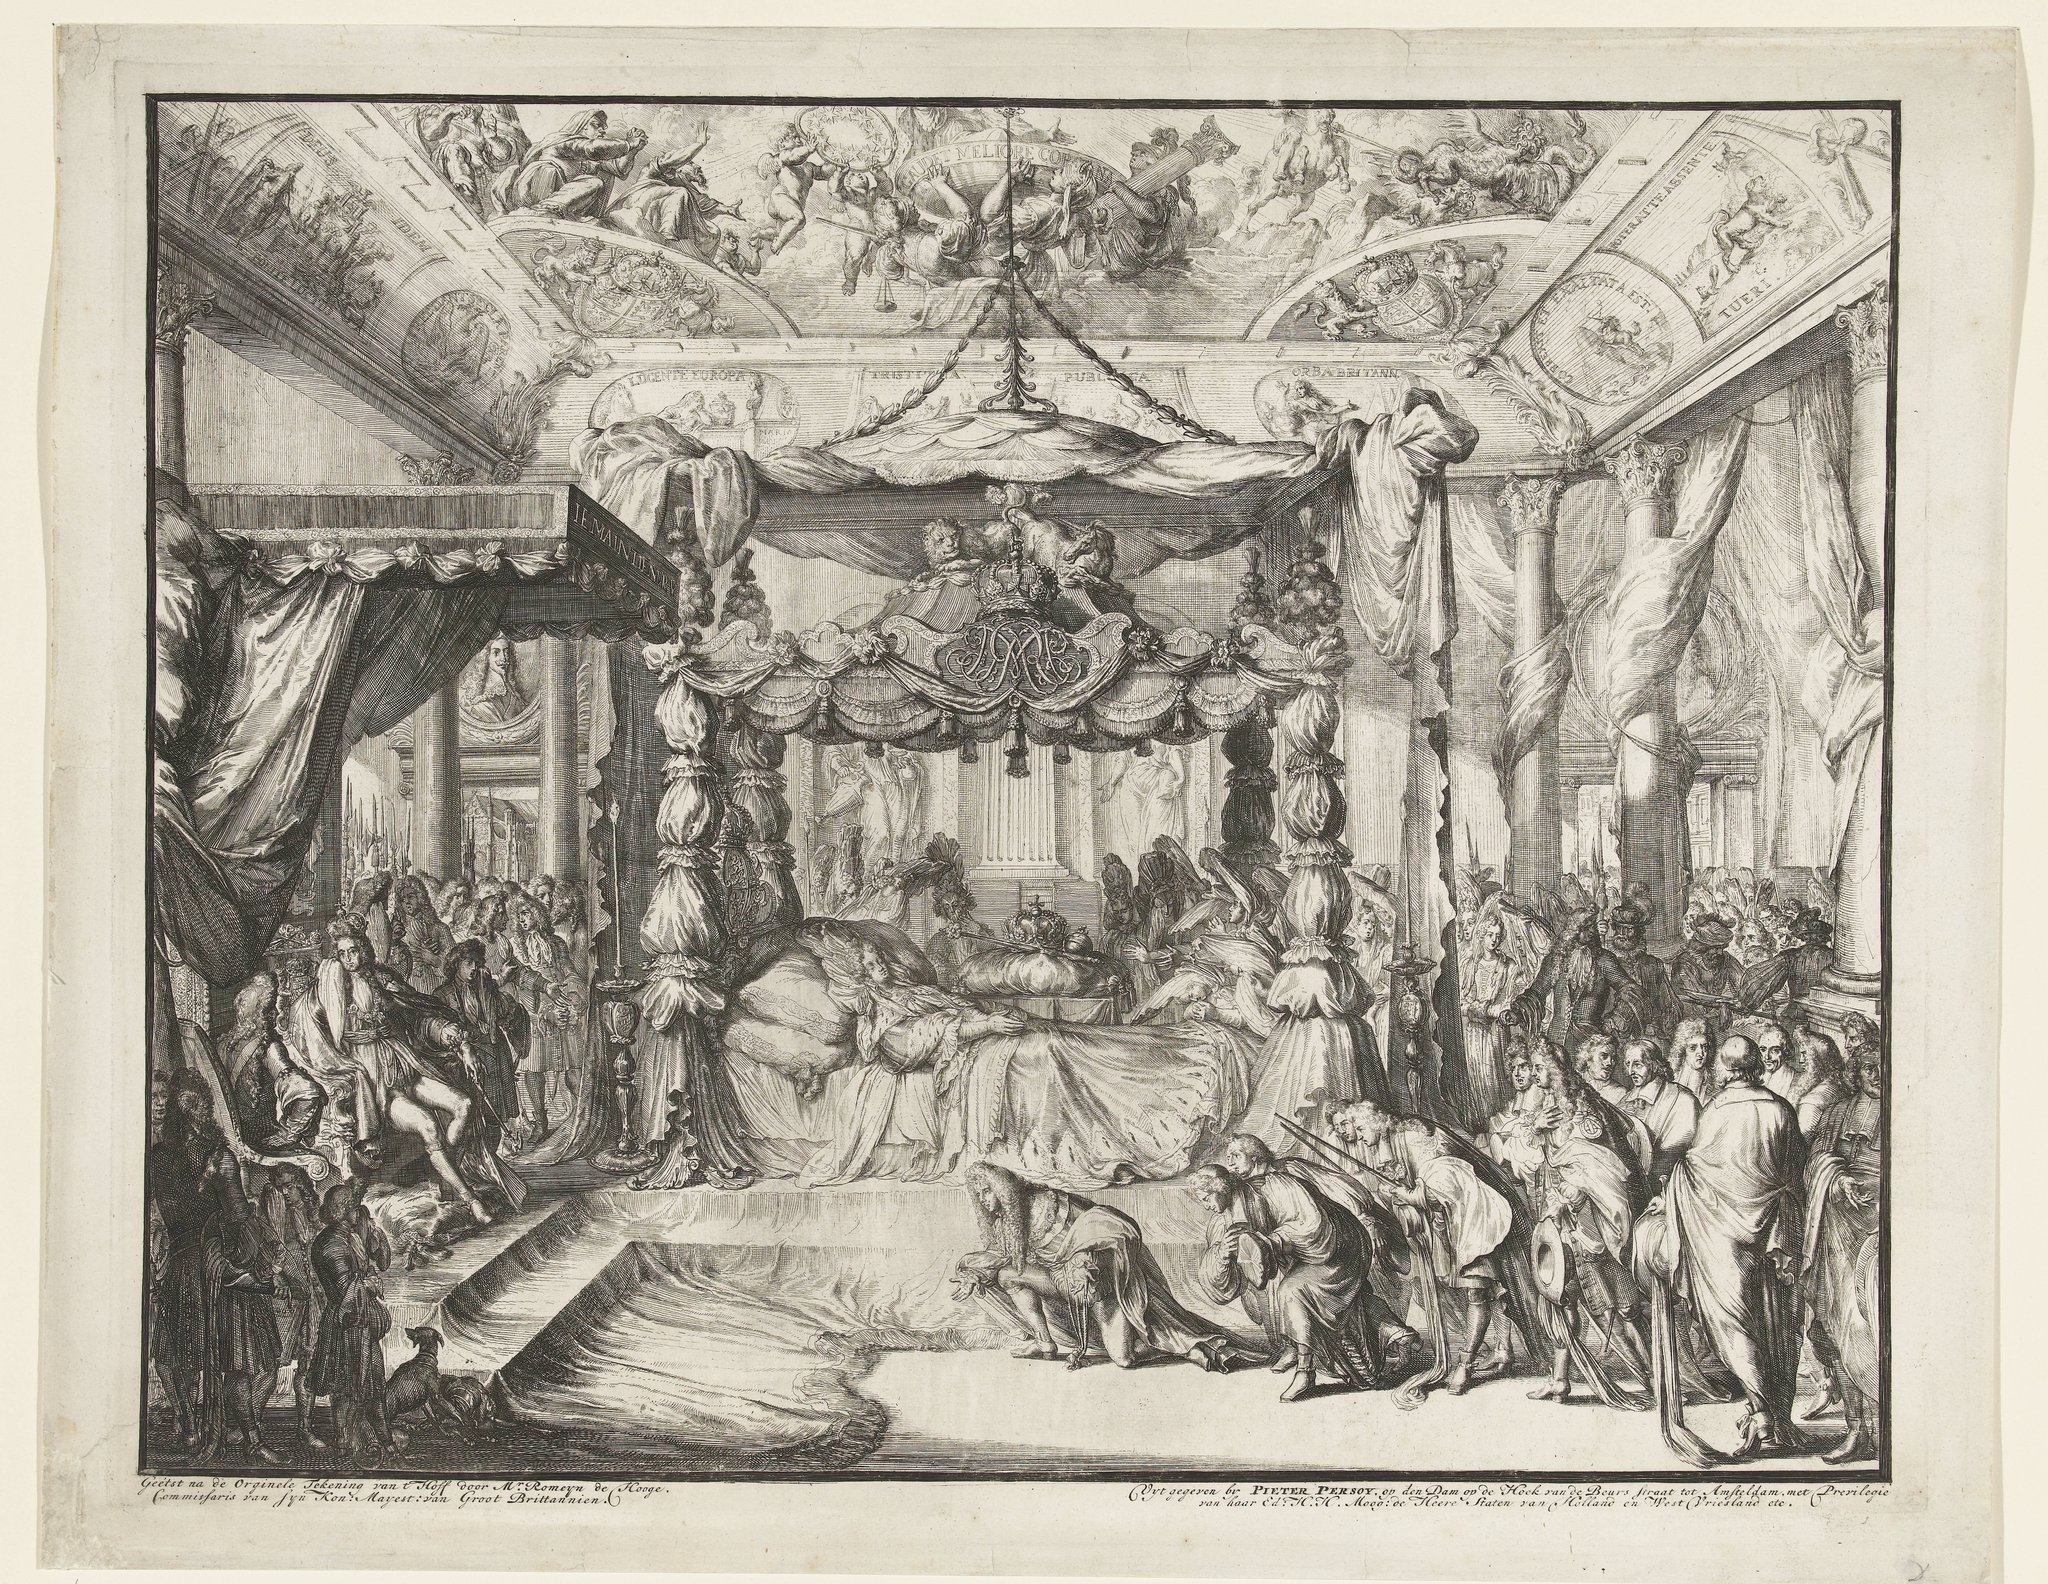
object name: print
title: Koningin Maria II Stuart op haar sterfbed, 1695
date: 1695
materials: paper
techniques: etching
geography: amsterdam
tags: the hague, william iii (prince of orange and king of england, scotland, and ireland), london, maria ii stuart (koningin van engeland, schotland en ierland), lying in state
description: Grote voorstelling van de kamer waarin koningin Maria II Stuart opgebaard ligt op haar sterfbed. Links zit de huilende Willem III op zijn troon.